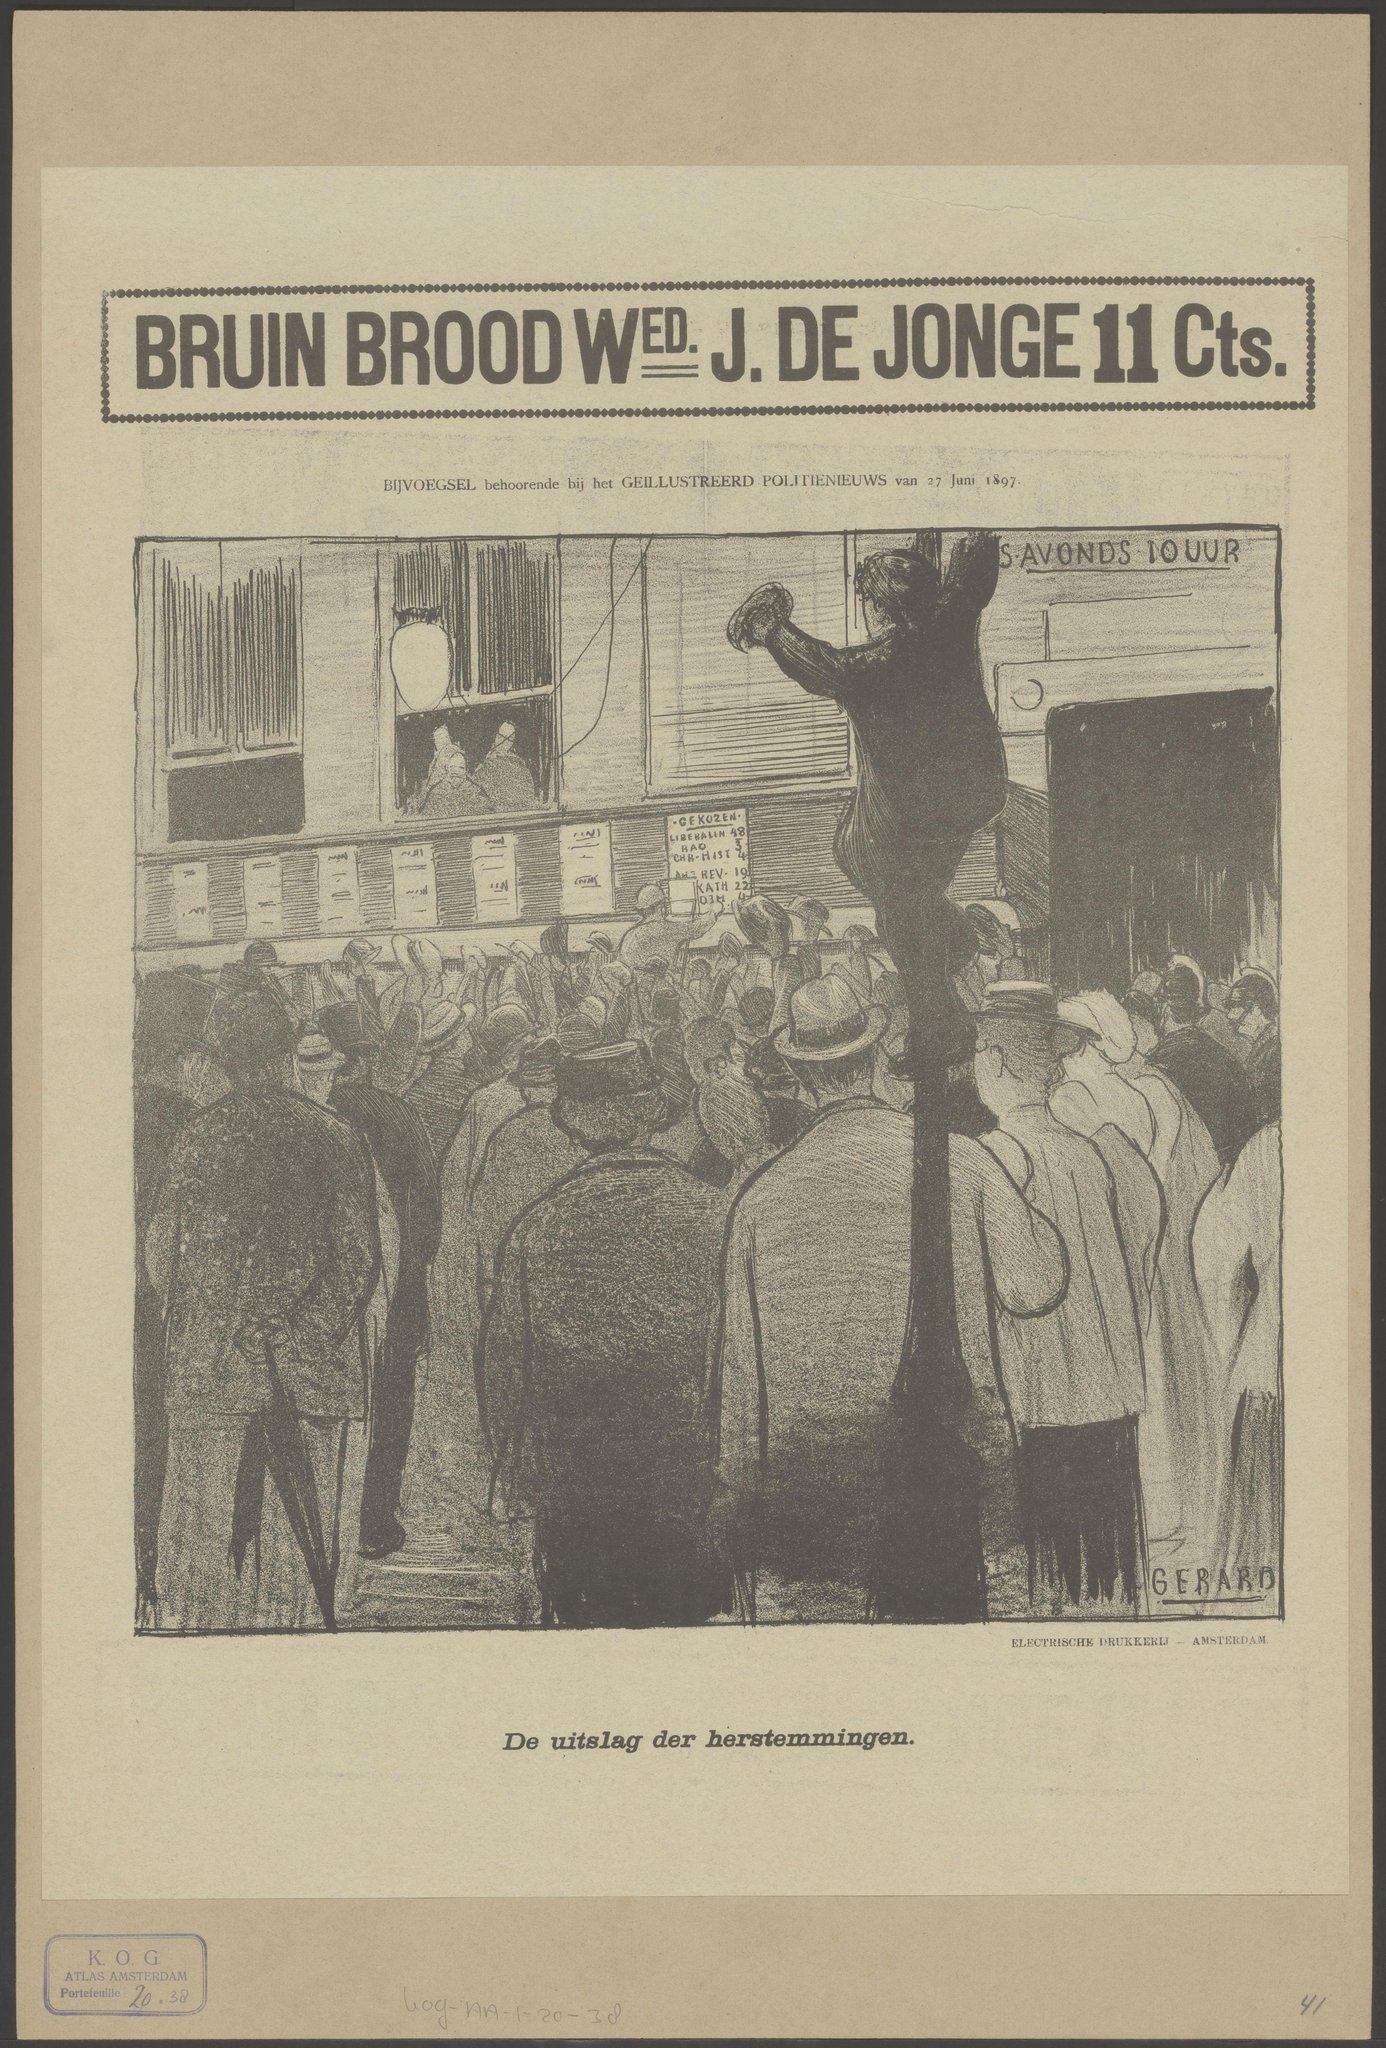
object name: print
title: Mensenmassa tijdens de bekendmaking van de verkiezingsuitslag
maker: Anonymous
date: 1897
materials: paper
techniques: letterpress printing, lithograph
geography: netherlands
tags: voting, election, amsterdam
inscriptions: signature: ‘GERARD’, collector's mark: Lugt 1641b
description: Gepubliceerd als bijvoegsel van 'Geïllustreerd Politie-Nieuws', 27 juni 1897.